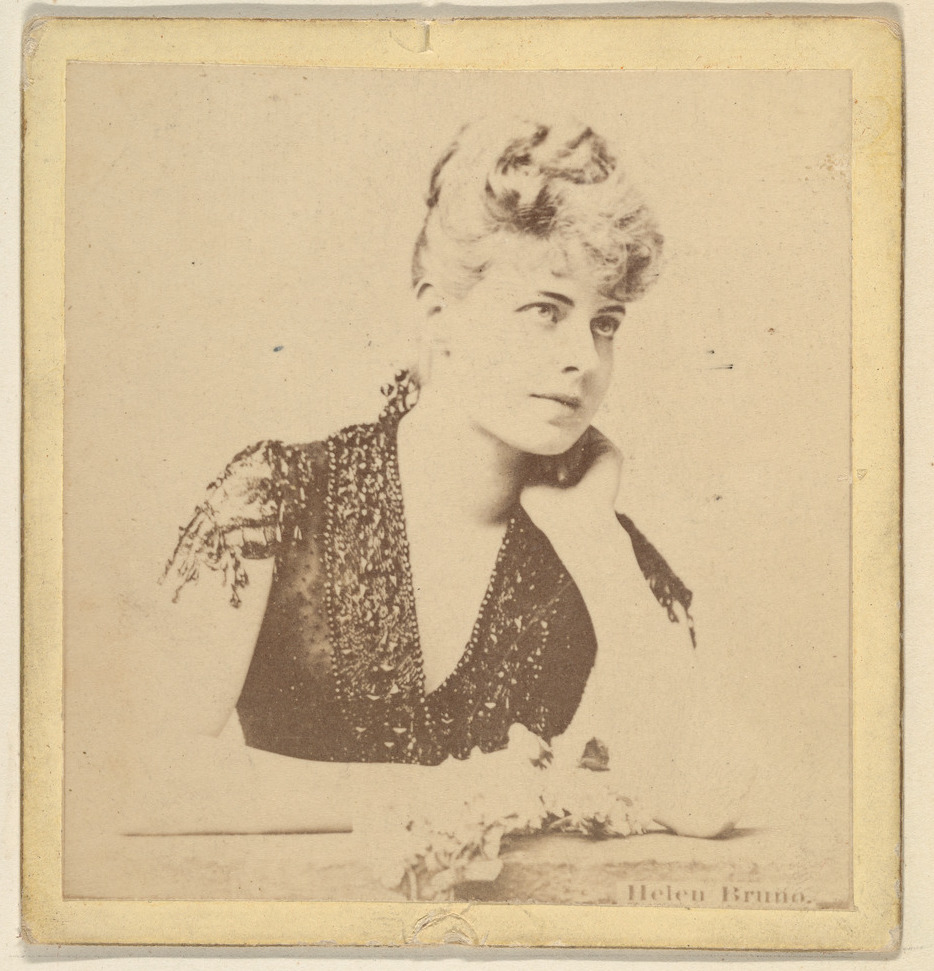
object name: photograph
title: Helen Bruno, from the Actresses series (N246), Type 2, issued by Kinney Brothers to promote Sporting Extra Cigarettes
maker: kinney brothers tobacco company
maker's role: publisher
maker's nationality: american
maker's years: 1869-2011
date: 1890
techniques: albumen silver print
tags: portraits,women,actresses